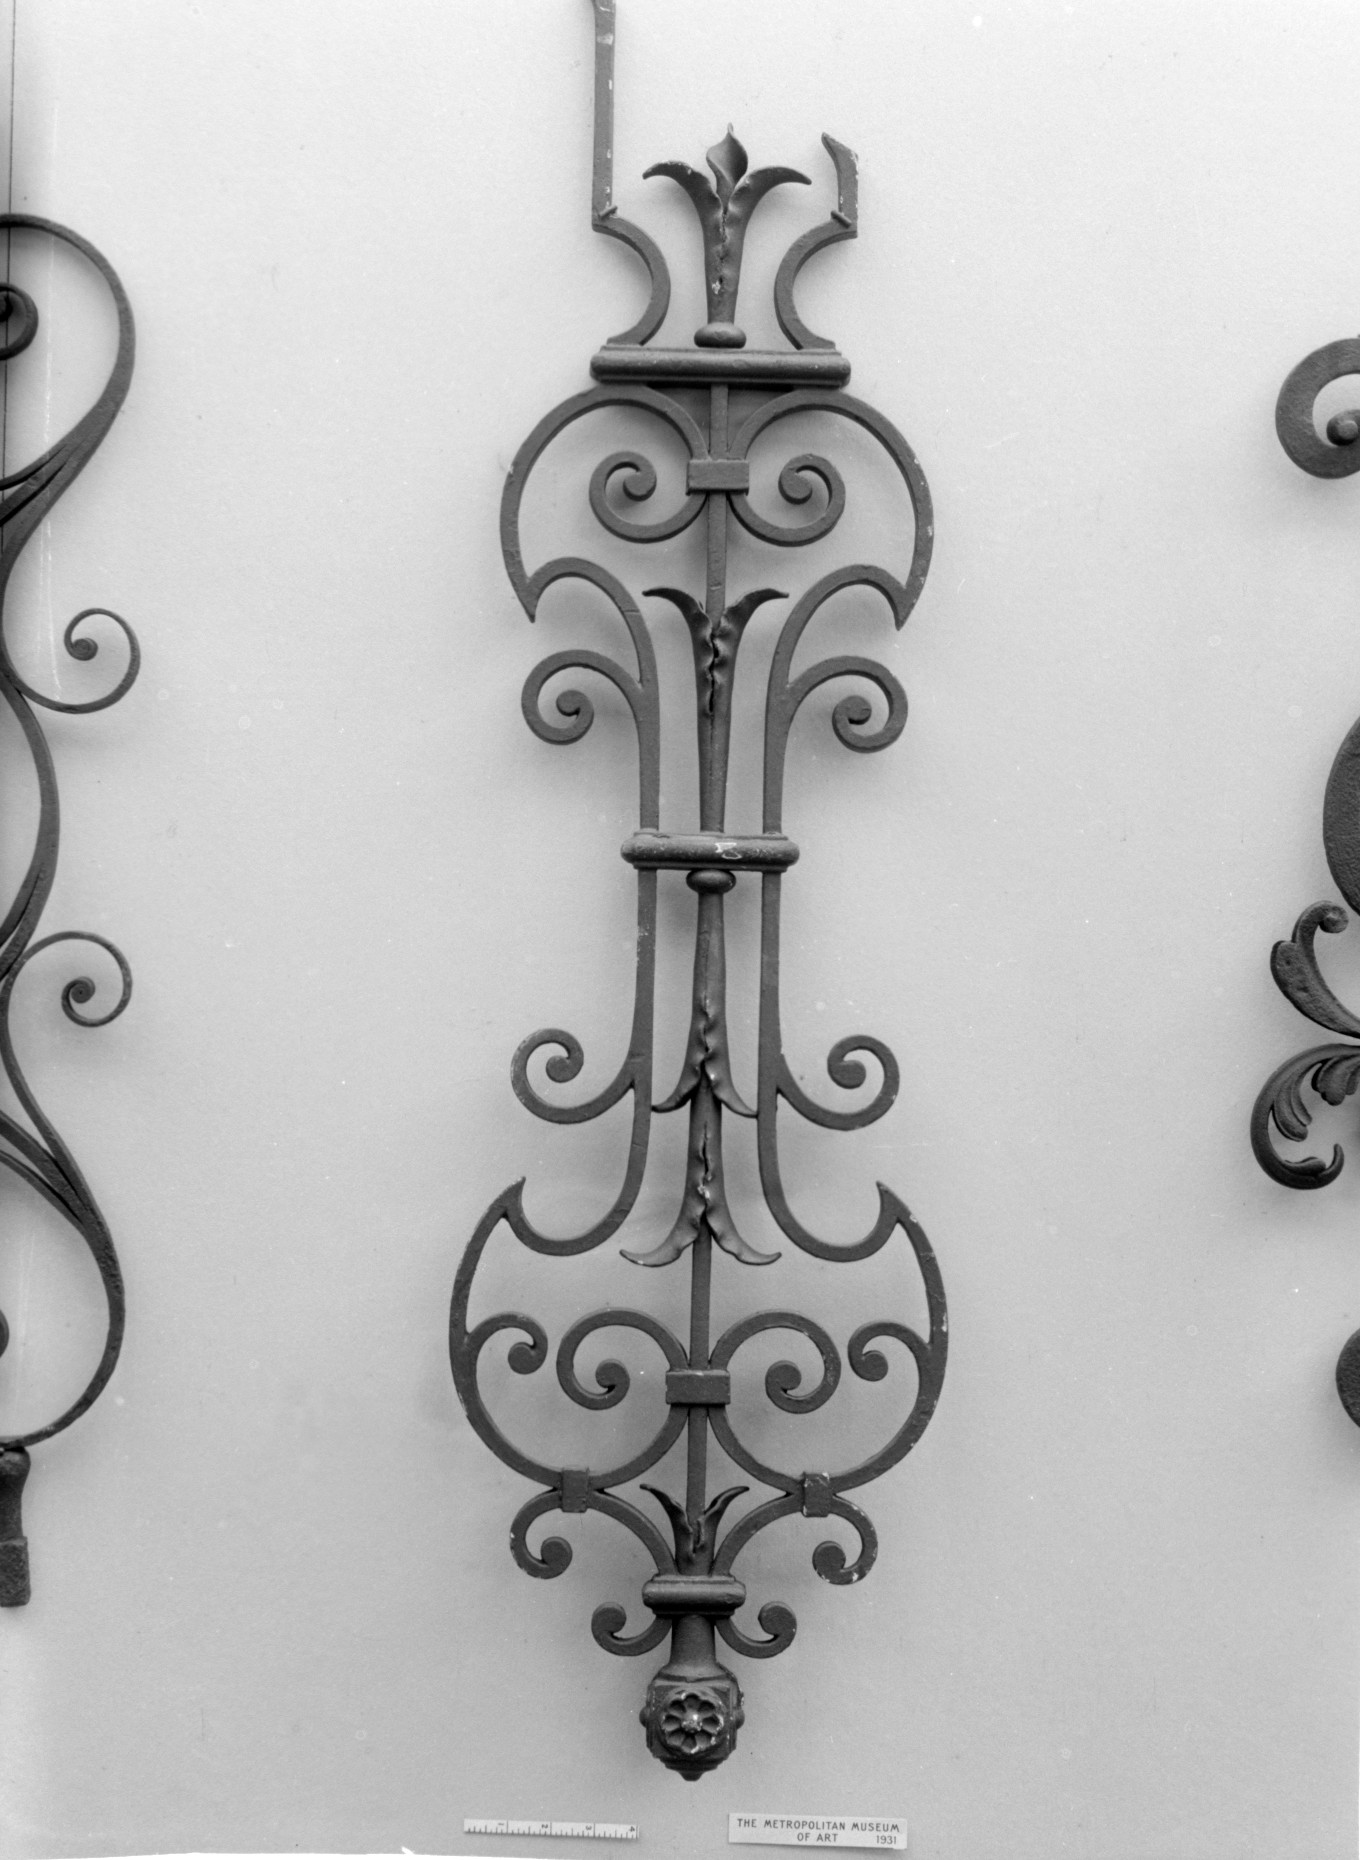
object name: baluster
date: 1800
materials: iron